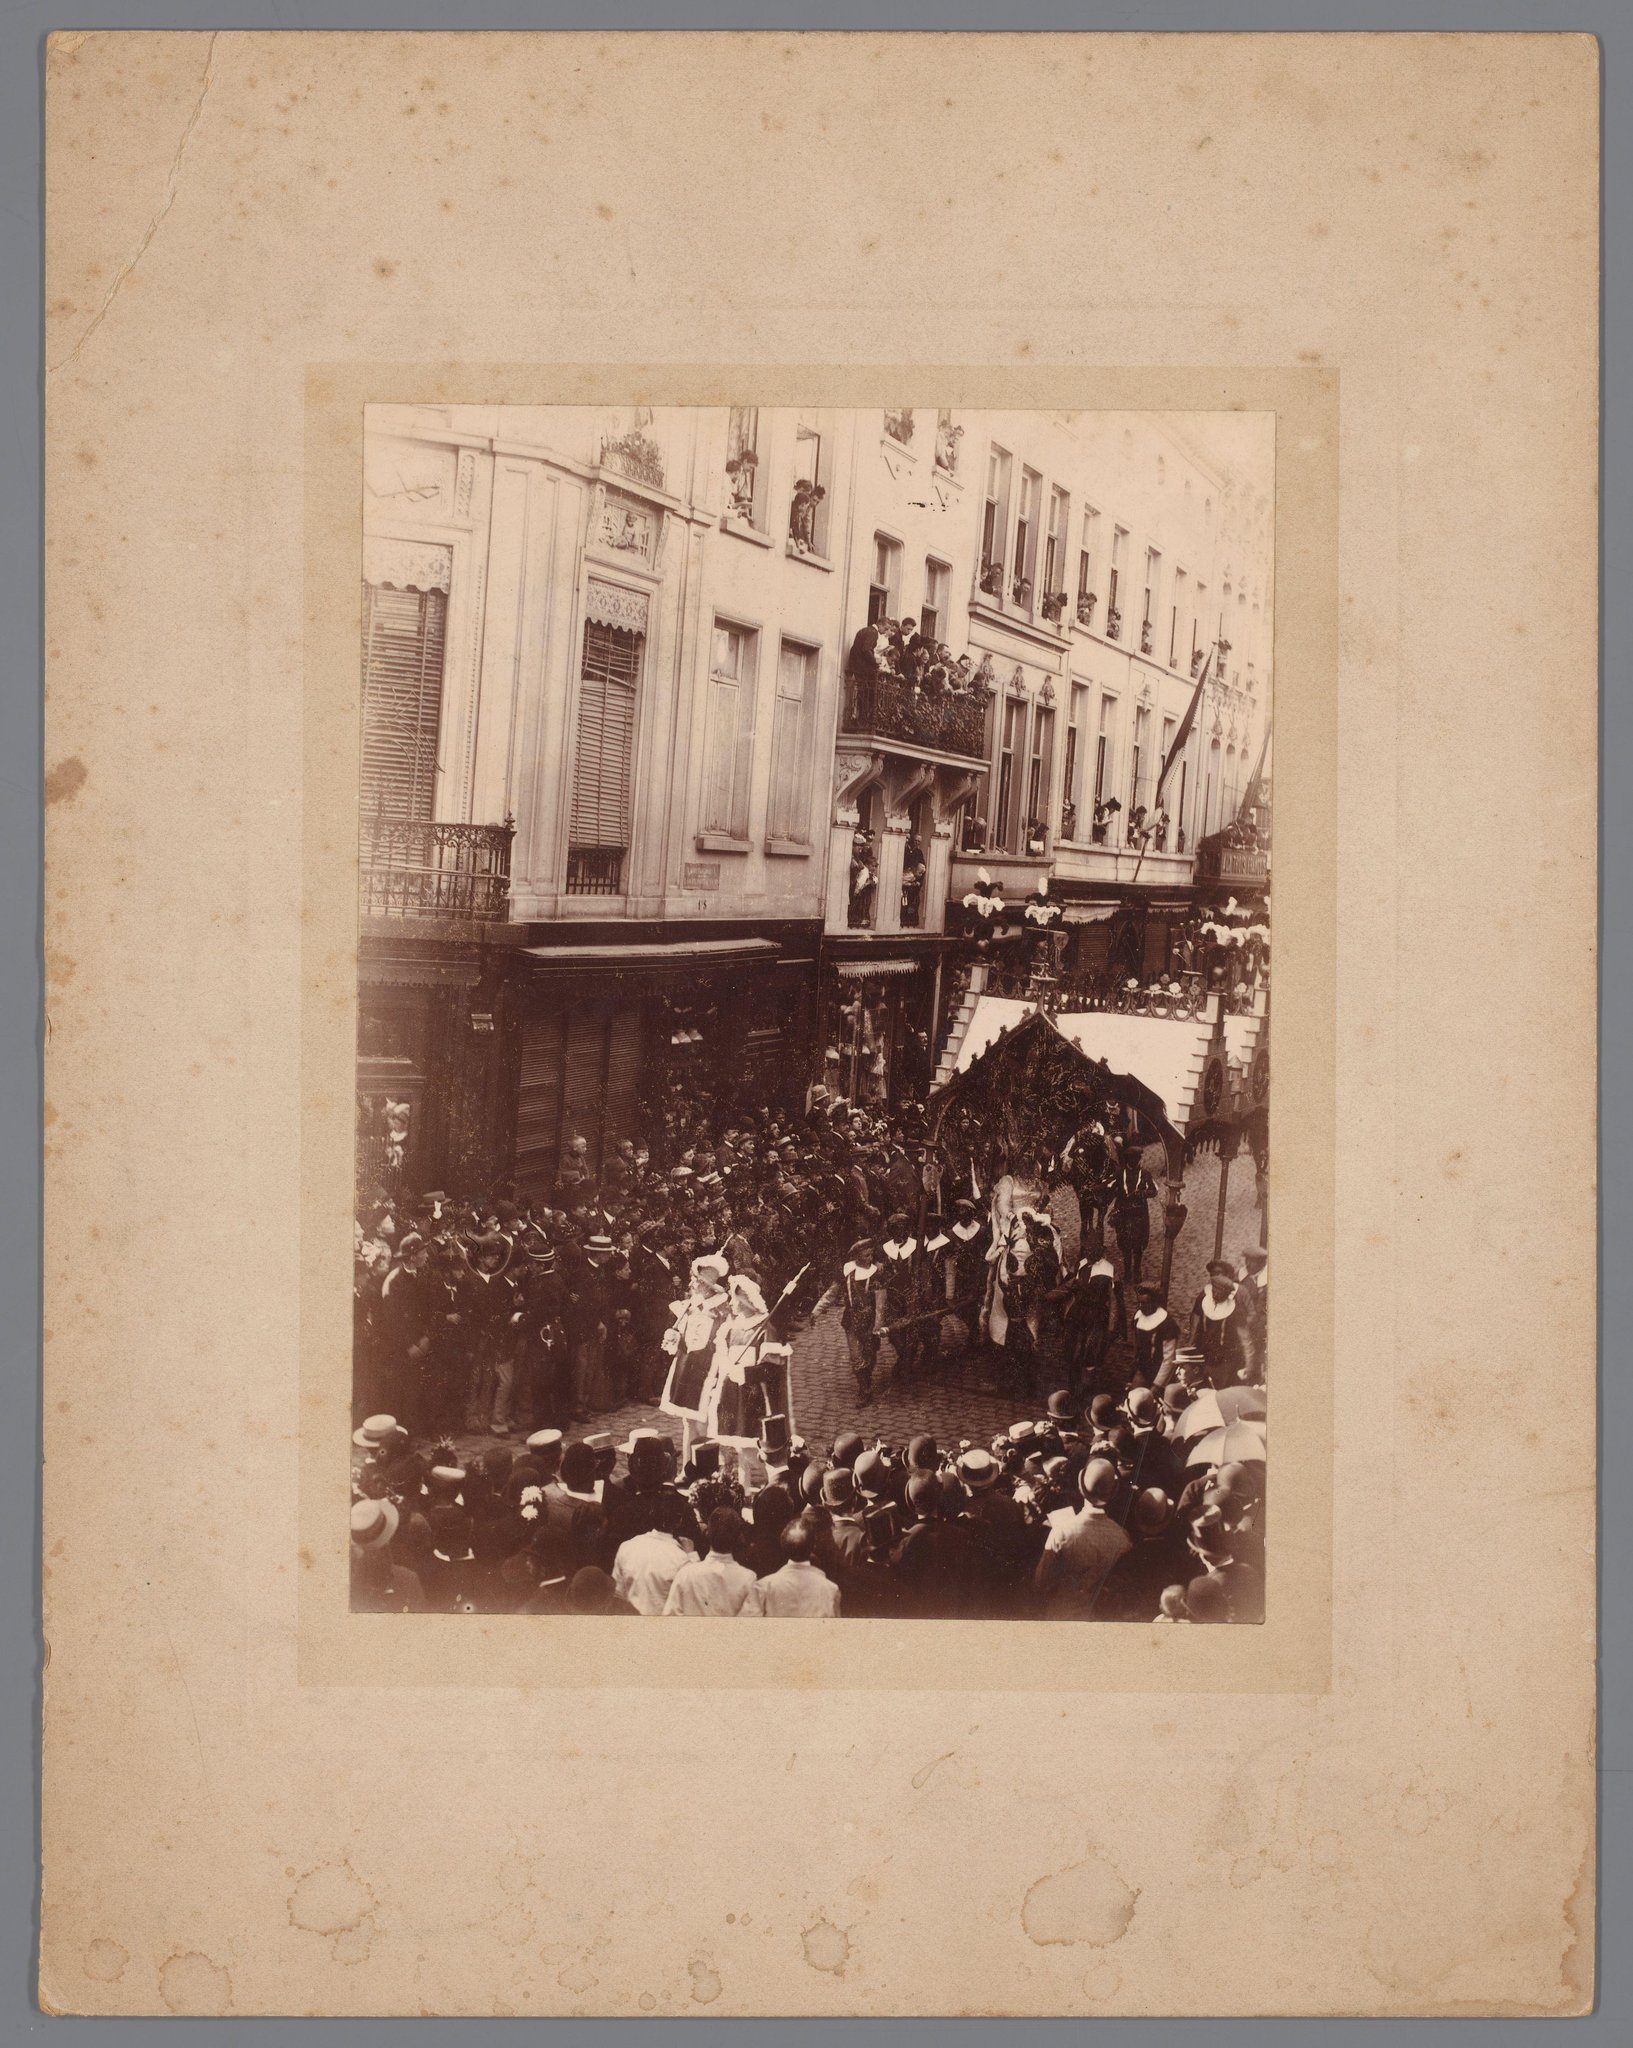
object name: photograph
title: Historische optocht (?) in België (?)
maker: Anonymous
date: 1880-1910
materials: cardboard, paper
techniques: collodion silver print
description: Historische optocht (?) in België (?). Straat in een stad, mensen met middeleeuwse kleding, een baldakijn met daaronder een draagbaar met vrouw. Langs de weg een café/winkel 'Aux Tres Enfants', en een straatnaambord (zonder loep niet leesbaar).